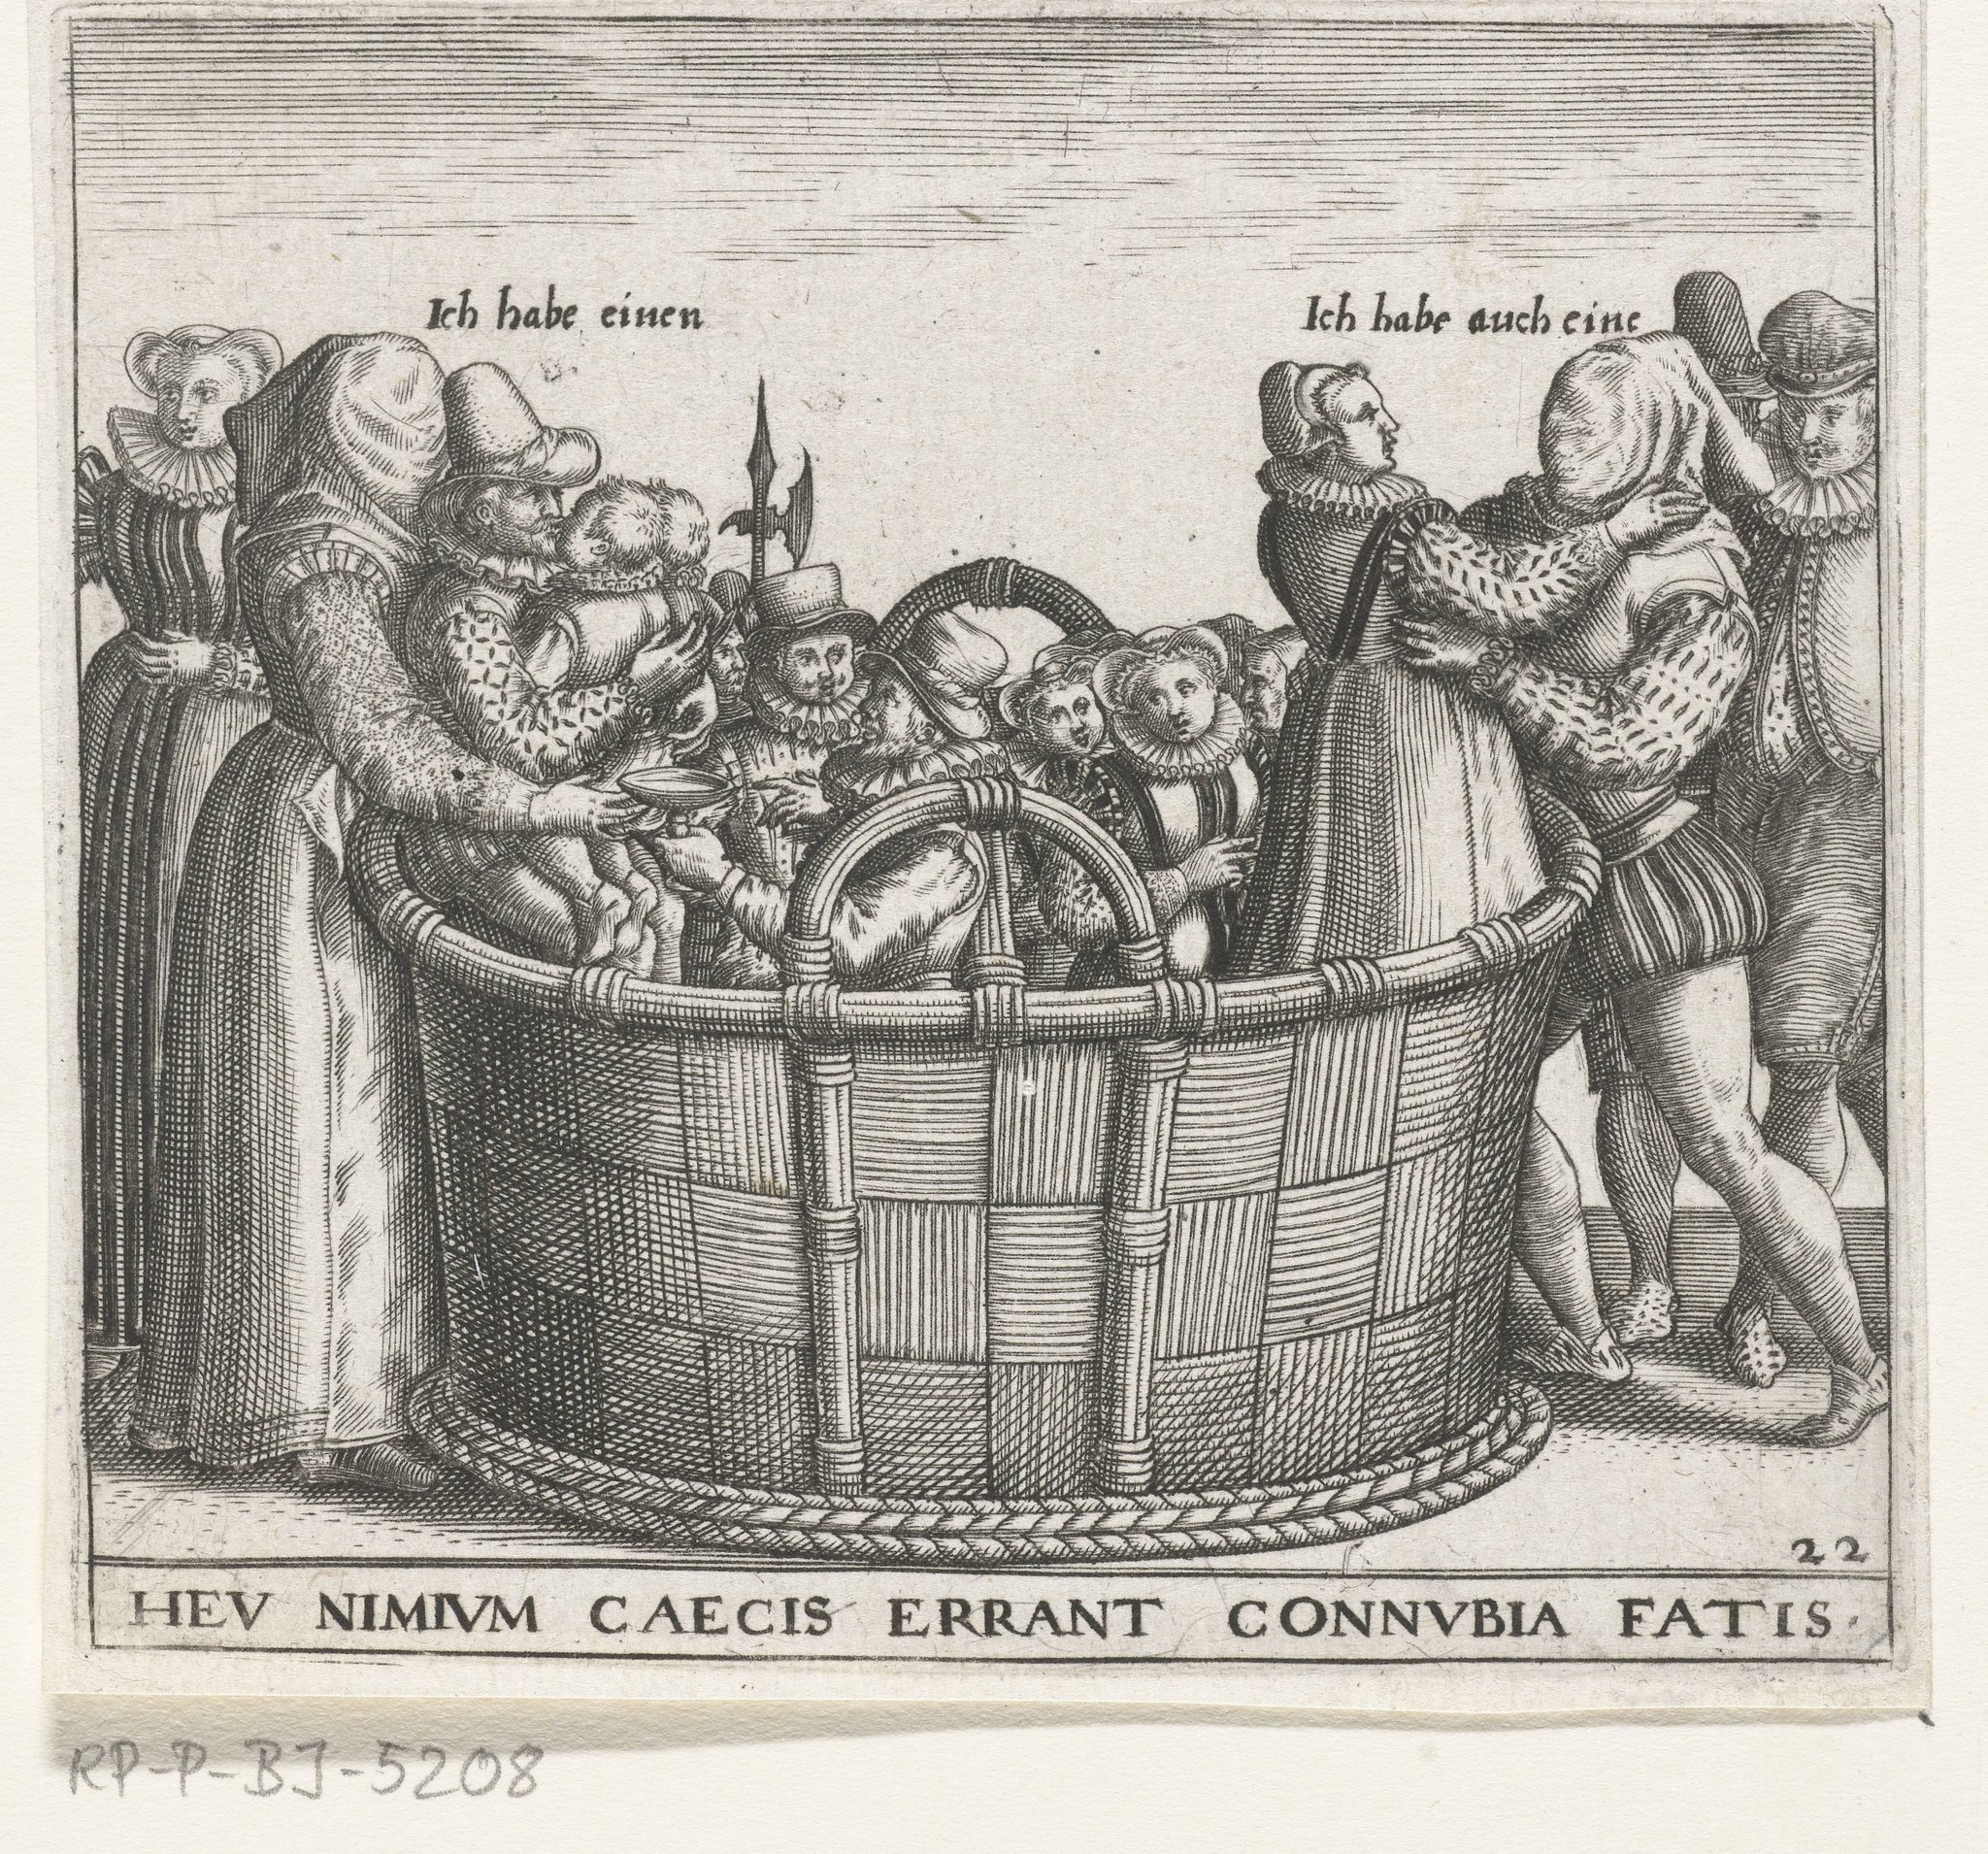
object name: cognizance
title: HEU NIMIUM VAECIS ERRANT CONNUBIA FATIS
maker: johann theodor de bry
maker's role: print maker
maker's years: 1561-1623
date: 1596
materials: paper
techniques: engraving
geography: frankfurt am main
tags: existence and modes of existence (+ emblematical representation of concept), blindfolded choice (of partner)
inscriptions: collector's mark: Lugt 240, inscription: ‘Ich habe einen / Ich habe auch eine’, inscription: ‘HEU NIMIUM VAECIS ERRANT CONNUBIA FATIS’, number: ‘22’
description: In een grote mand zitten mannen en vrouwen als mogelijke huwelijkskandidaten. Naast de mand staan een man en een vrouw met een zak over hun hoofd: zo kunnen ze de gebreken van de huwelijkskandidaten niet zien. Ze kiezen ze blindelings. De vrouw links trekt een weduwnaar uit de mand die in zijn armen twee kinderen houdt. De man rechts heeft een vrouw te pakken. Embleem nr. 22 in Emblemata Saecularia, 1596 en nr. 43 in de tweede uitgave van 1611.